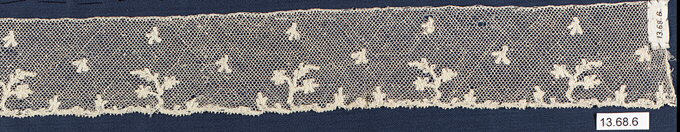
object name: fragment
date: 1801-1833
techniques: lace